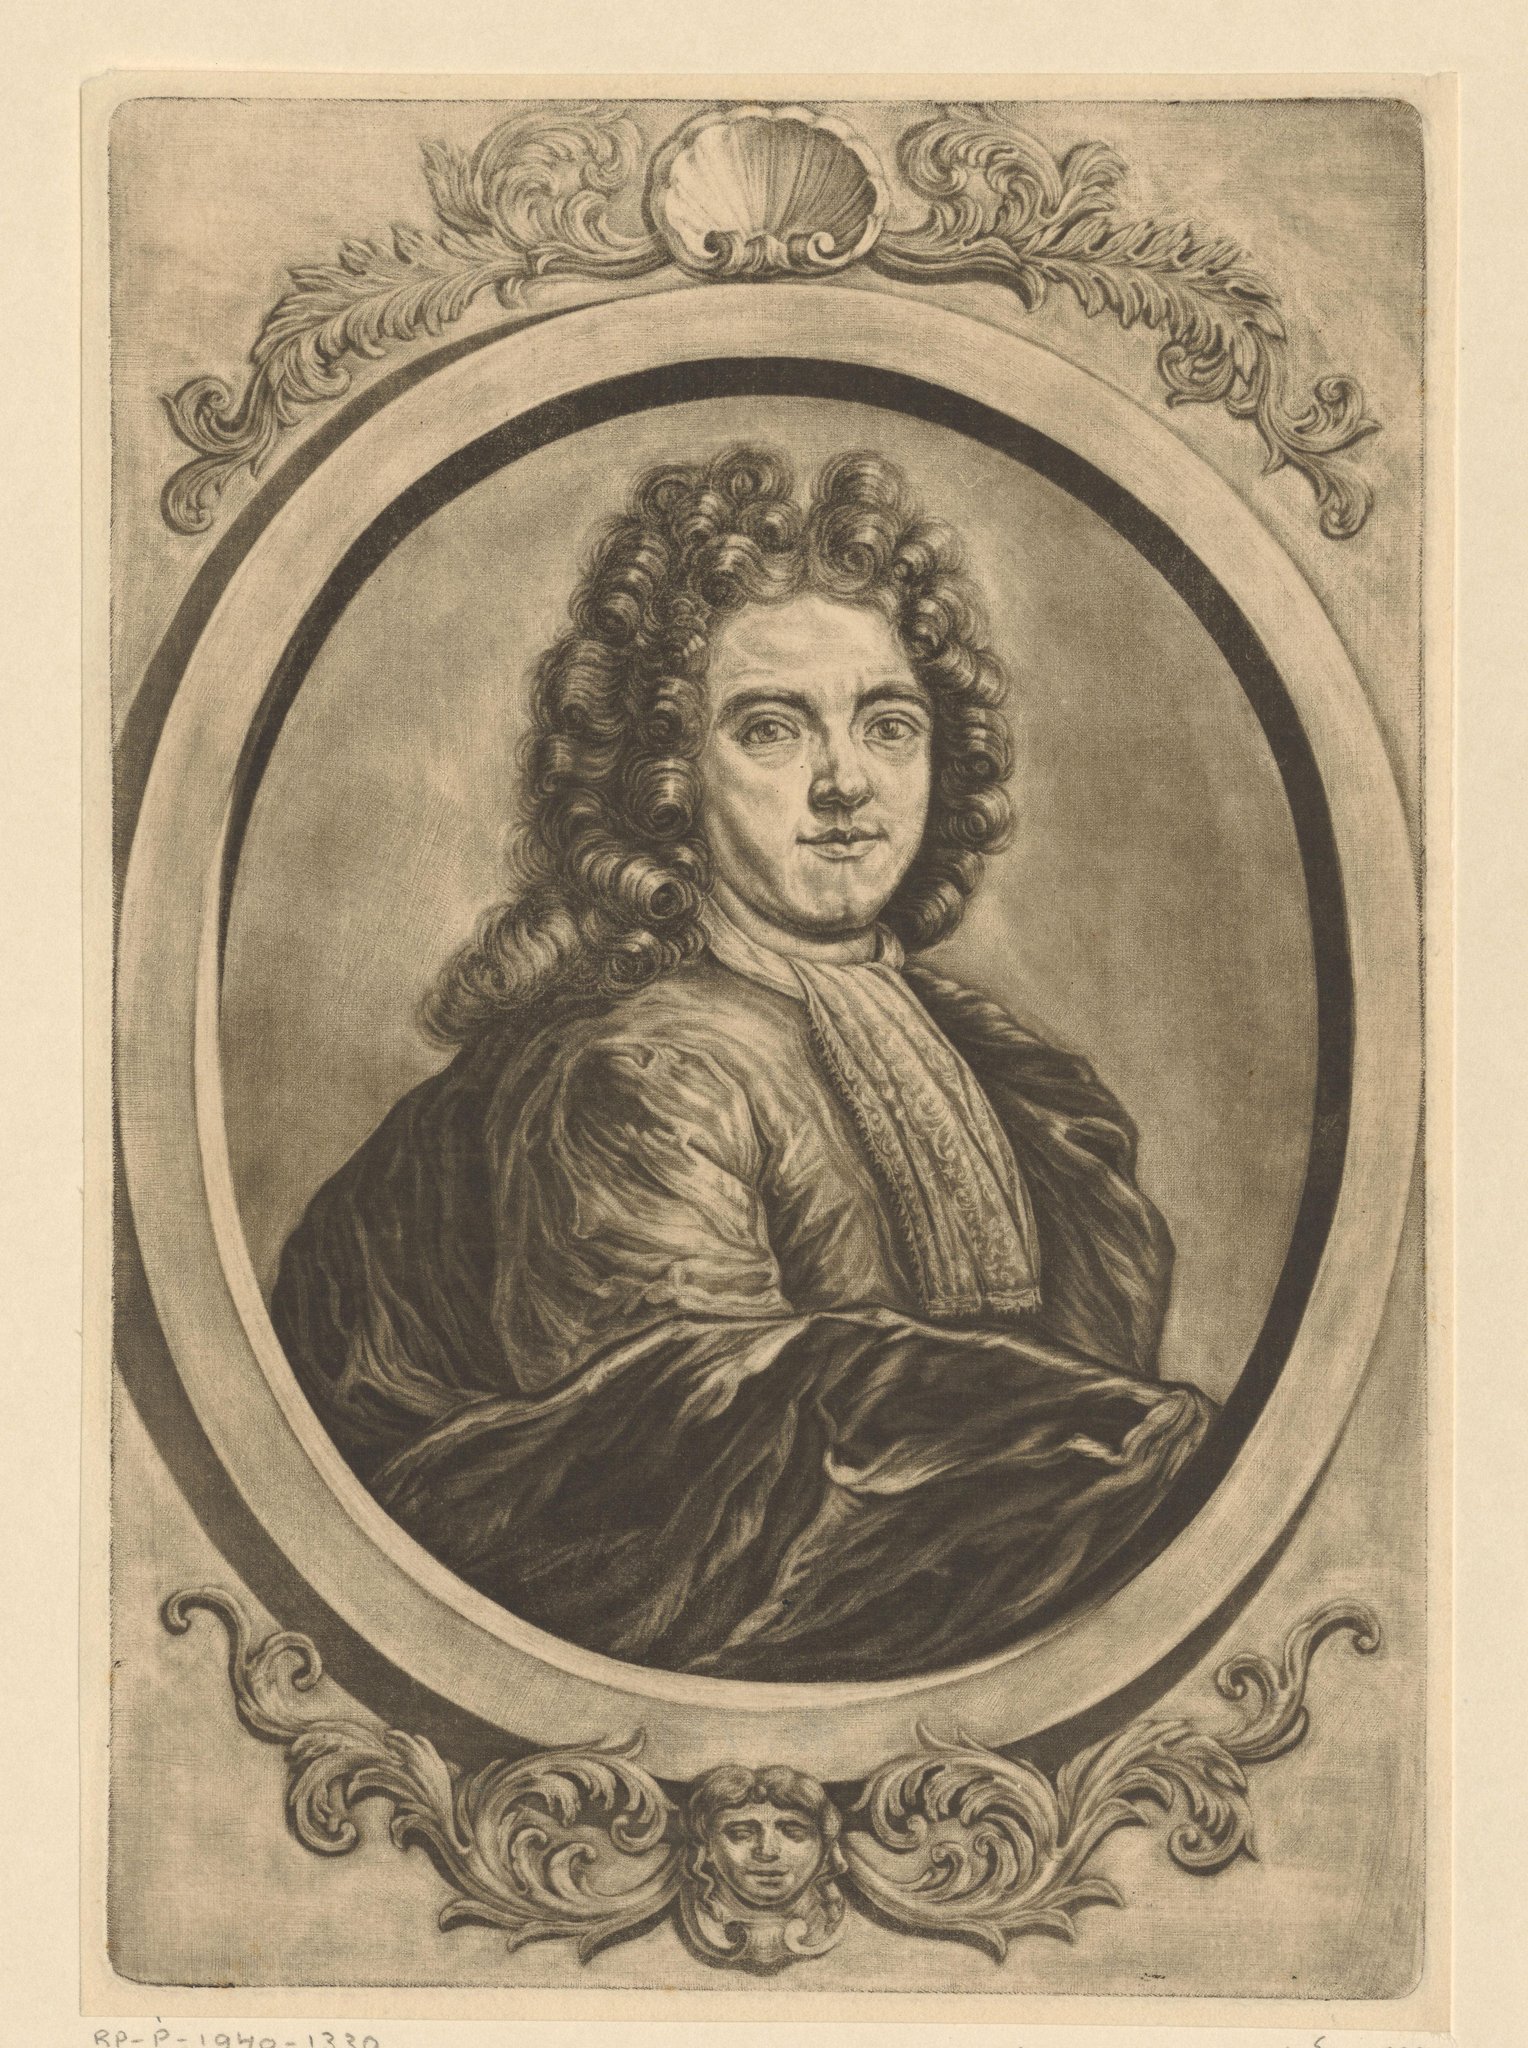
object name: print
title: Zelfportret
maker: arnoud van halen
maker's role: draughtsman, painter, print maker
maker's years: 1673-1732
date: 1683-1732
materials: paper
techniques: mezzotint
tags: amsterdam, painter, draughtsman, arnoud van halen, historical persons, portrait, self-portrait of graphic artist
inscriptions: collector's mark: Lugt 2166, collector's mark: Lugt 2760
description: Op het opzetvel is een strookje papier geplakt met de handgeschreven tekst: 'Arnold van Halem, schilder & teekenaar. Door hemzelfs geschraapt.'